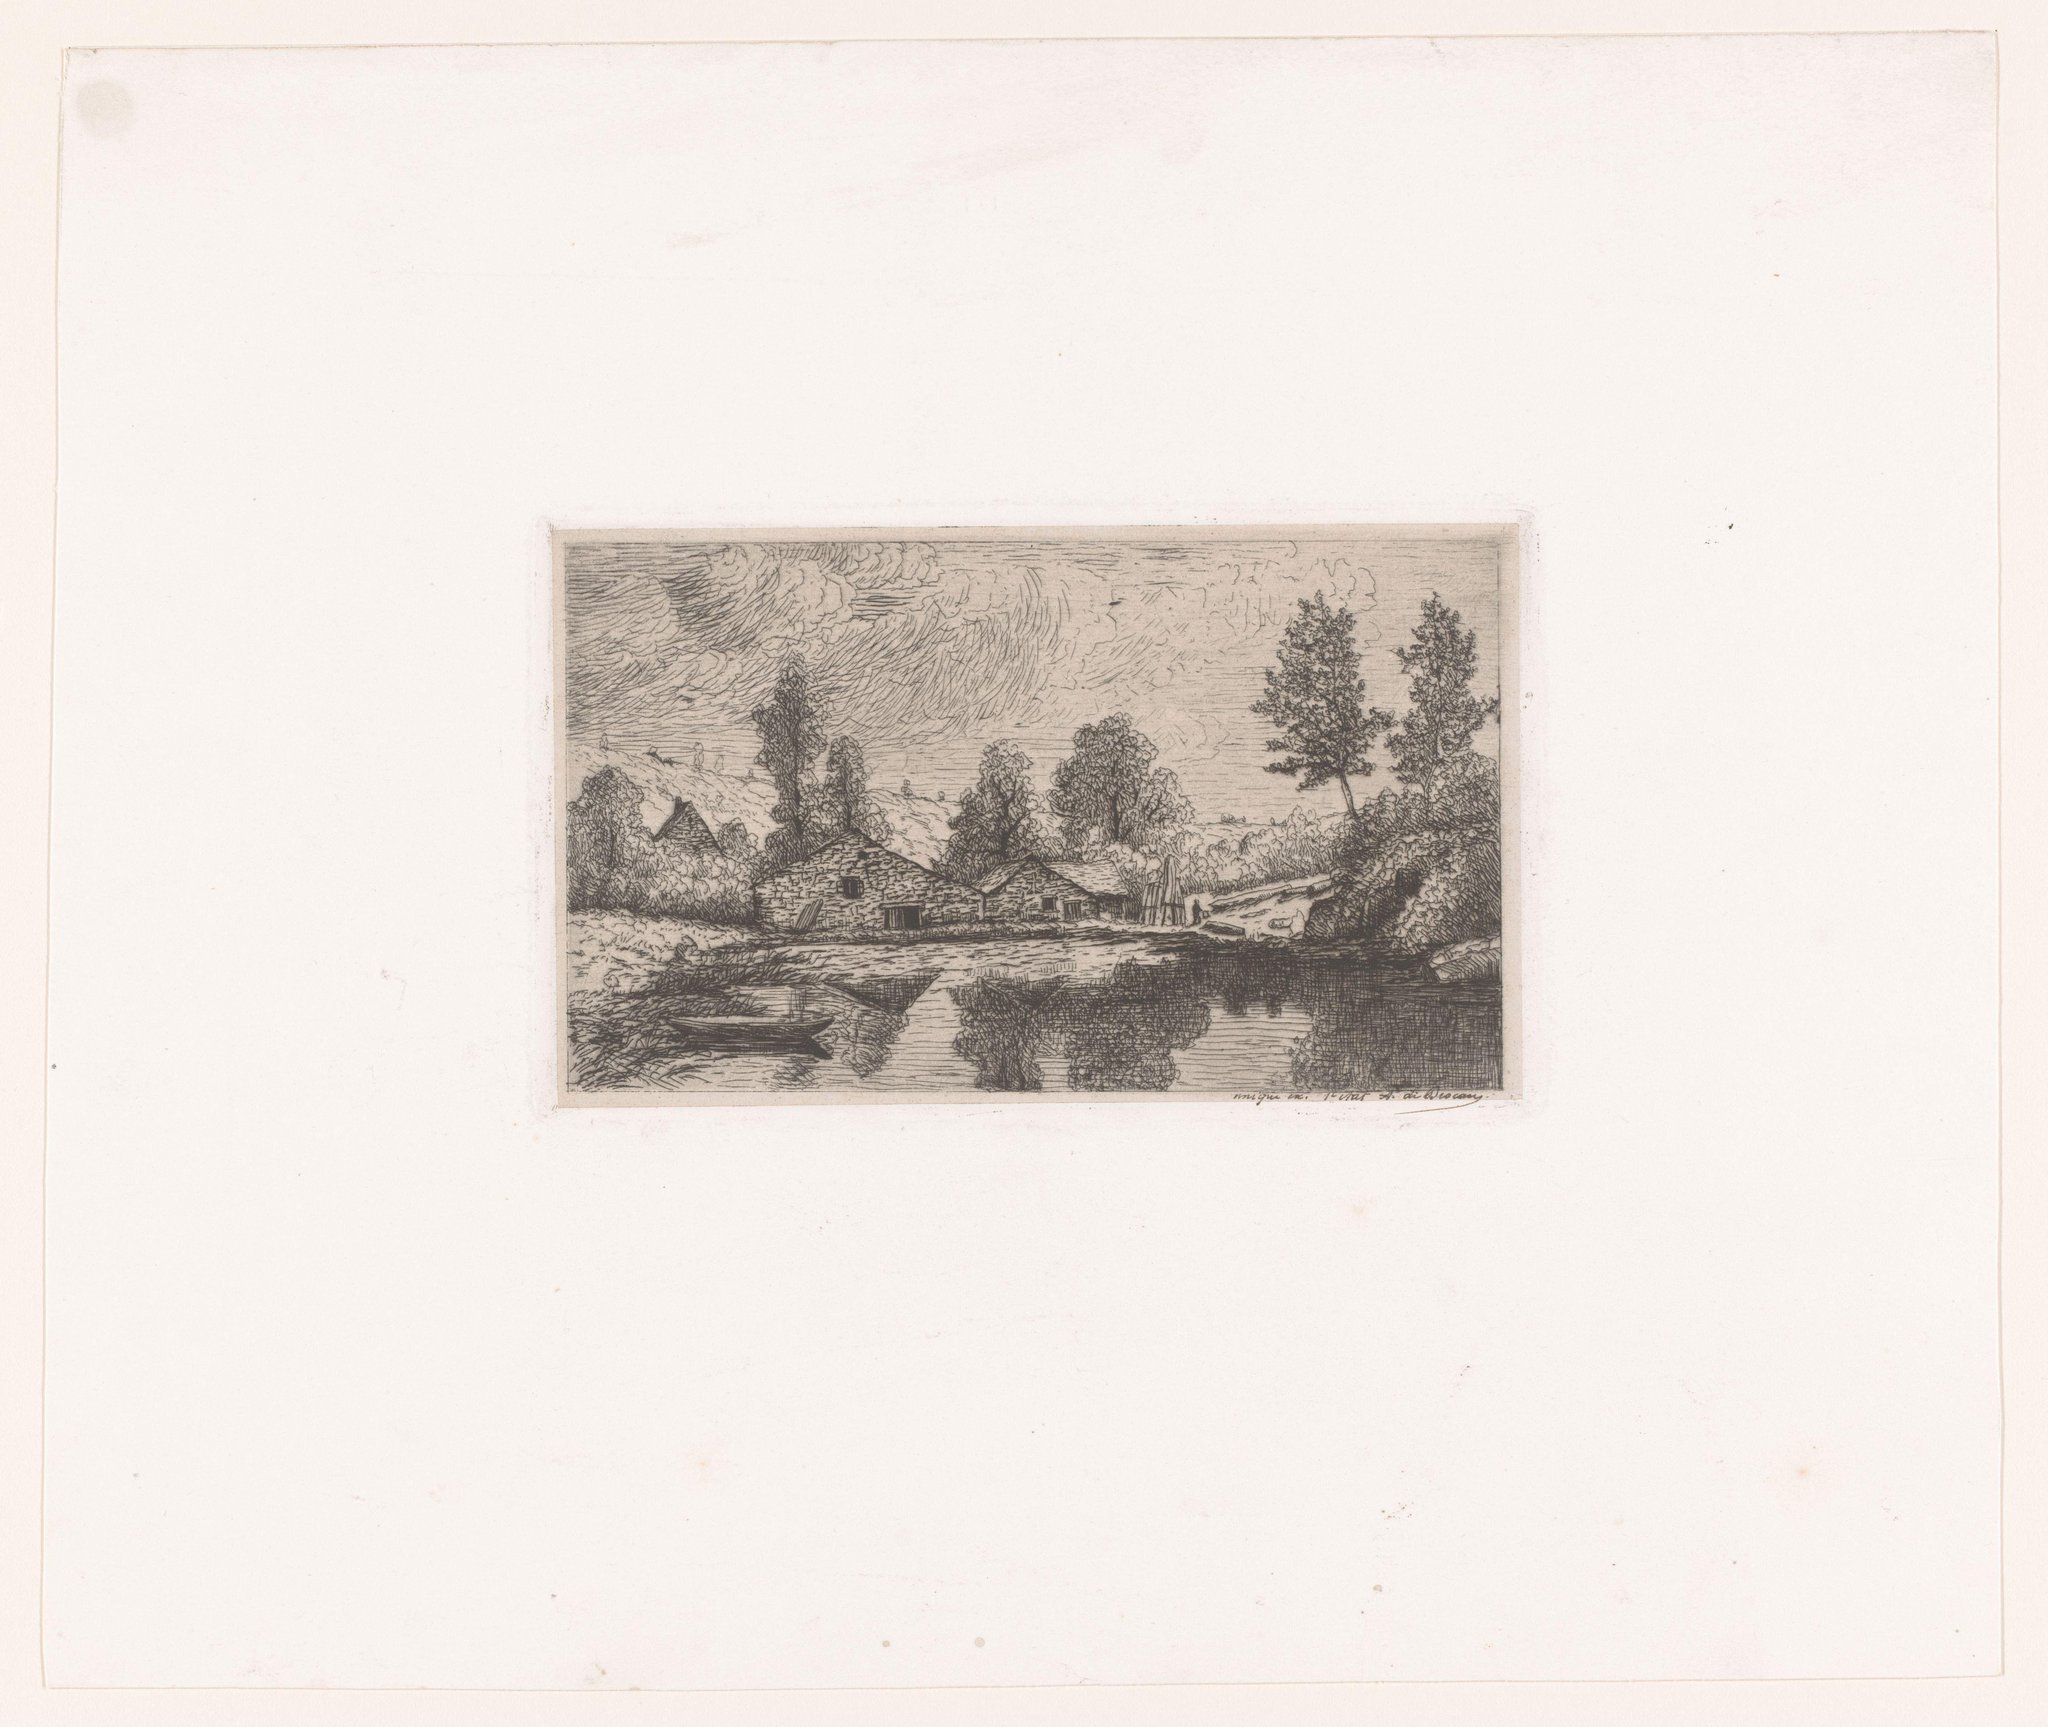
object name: print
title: Boerderijen achter een meer met een roeiboot in het water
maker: aristide de biseau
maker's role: print maker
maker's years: 1844-1883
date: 1854-1883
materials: paper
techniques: etching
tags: rowing-boat, canoe, etc., farm or solitary house in landscape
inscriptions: annotation: ‘unique ex. 1e etat’